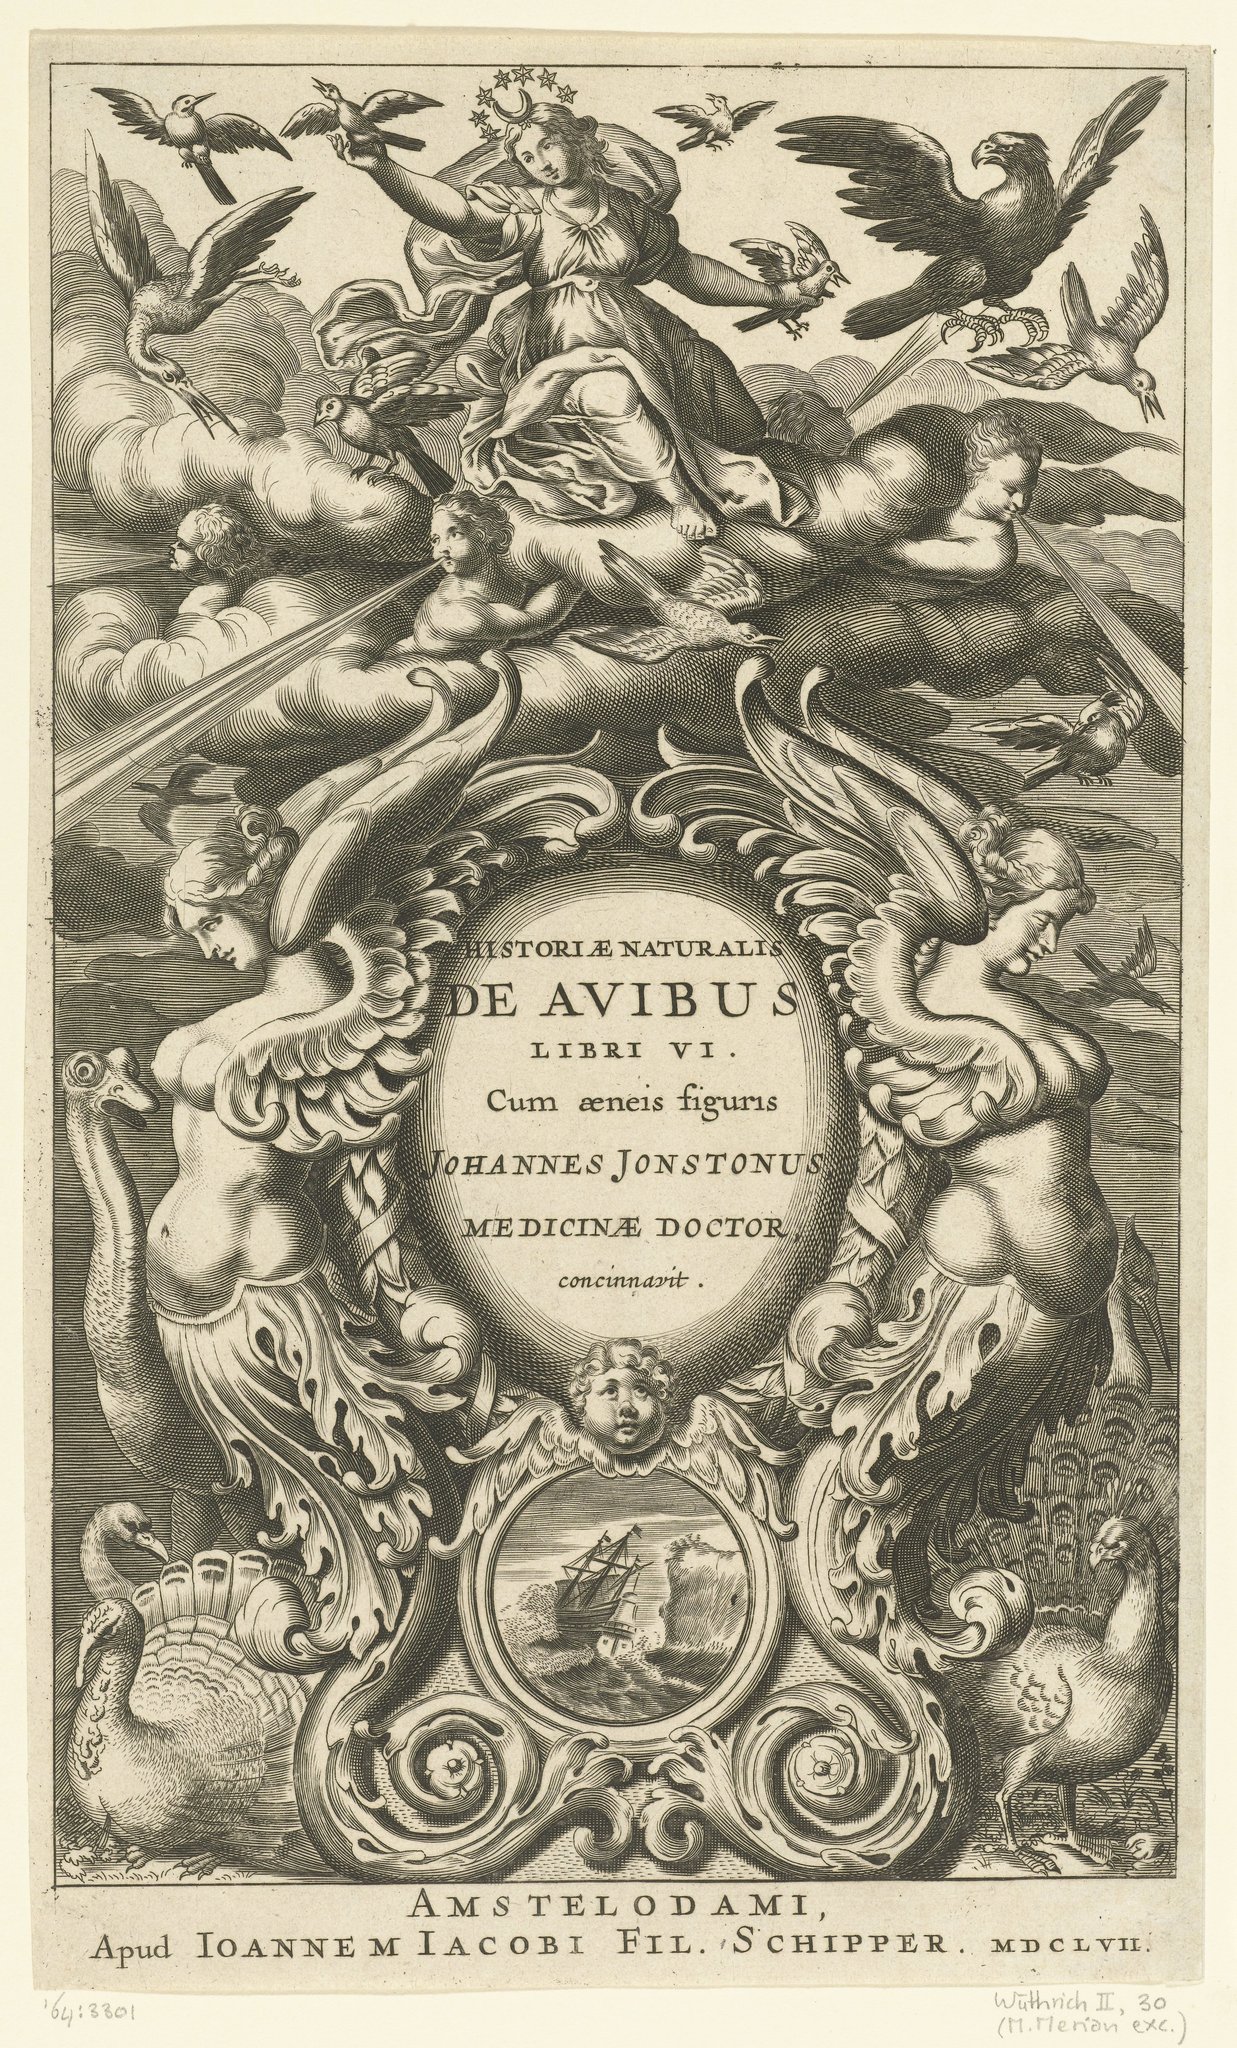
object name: ornament print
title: Titelblad: Historiae Naturalis de Avibus Libri VI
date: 1657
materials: paper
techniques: engraving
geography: amsterdam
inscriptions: date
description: De titel staat in een cartouche met aan weerszijden een engel wier onderlichaam uitloopt in bladranken.